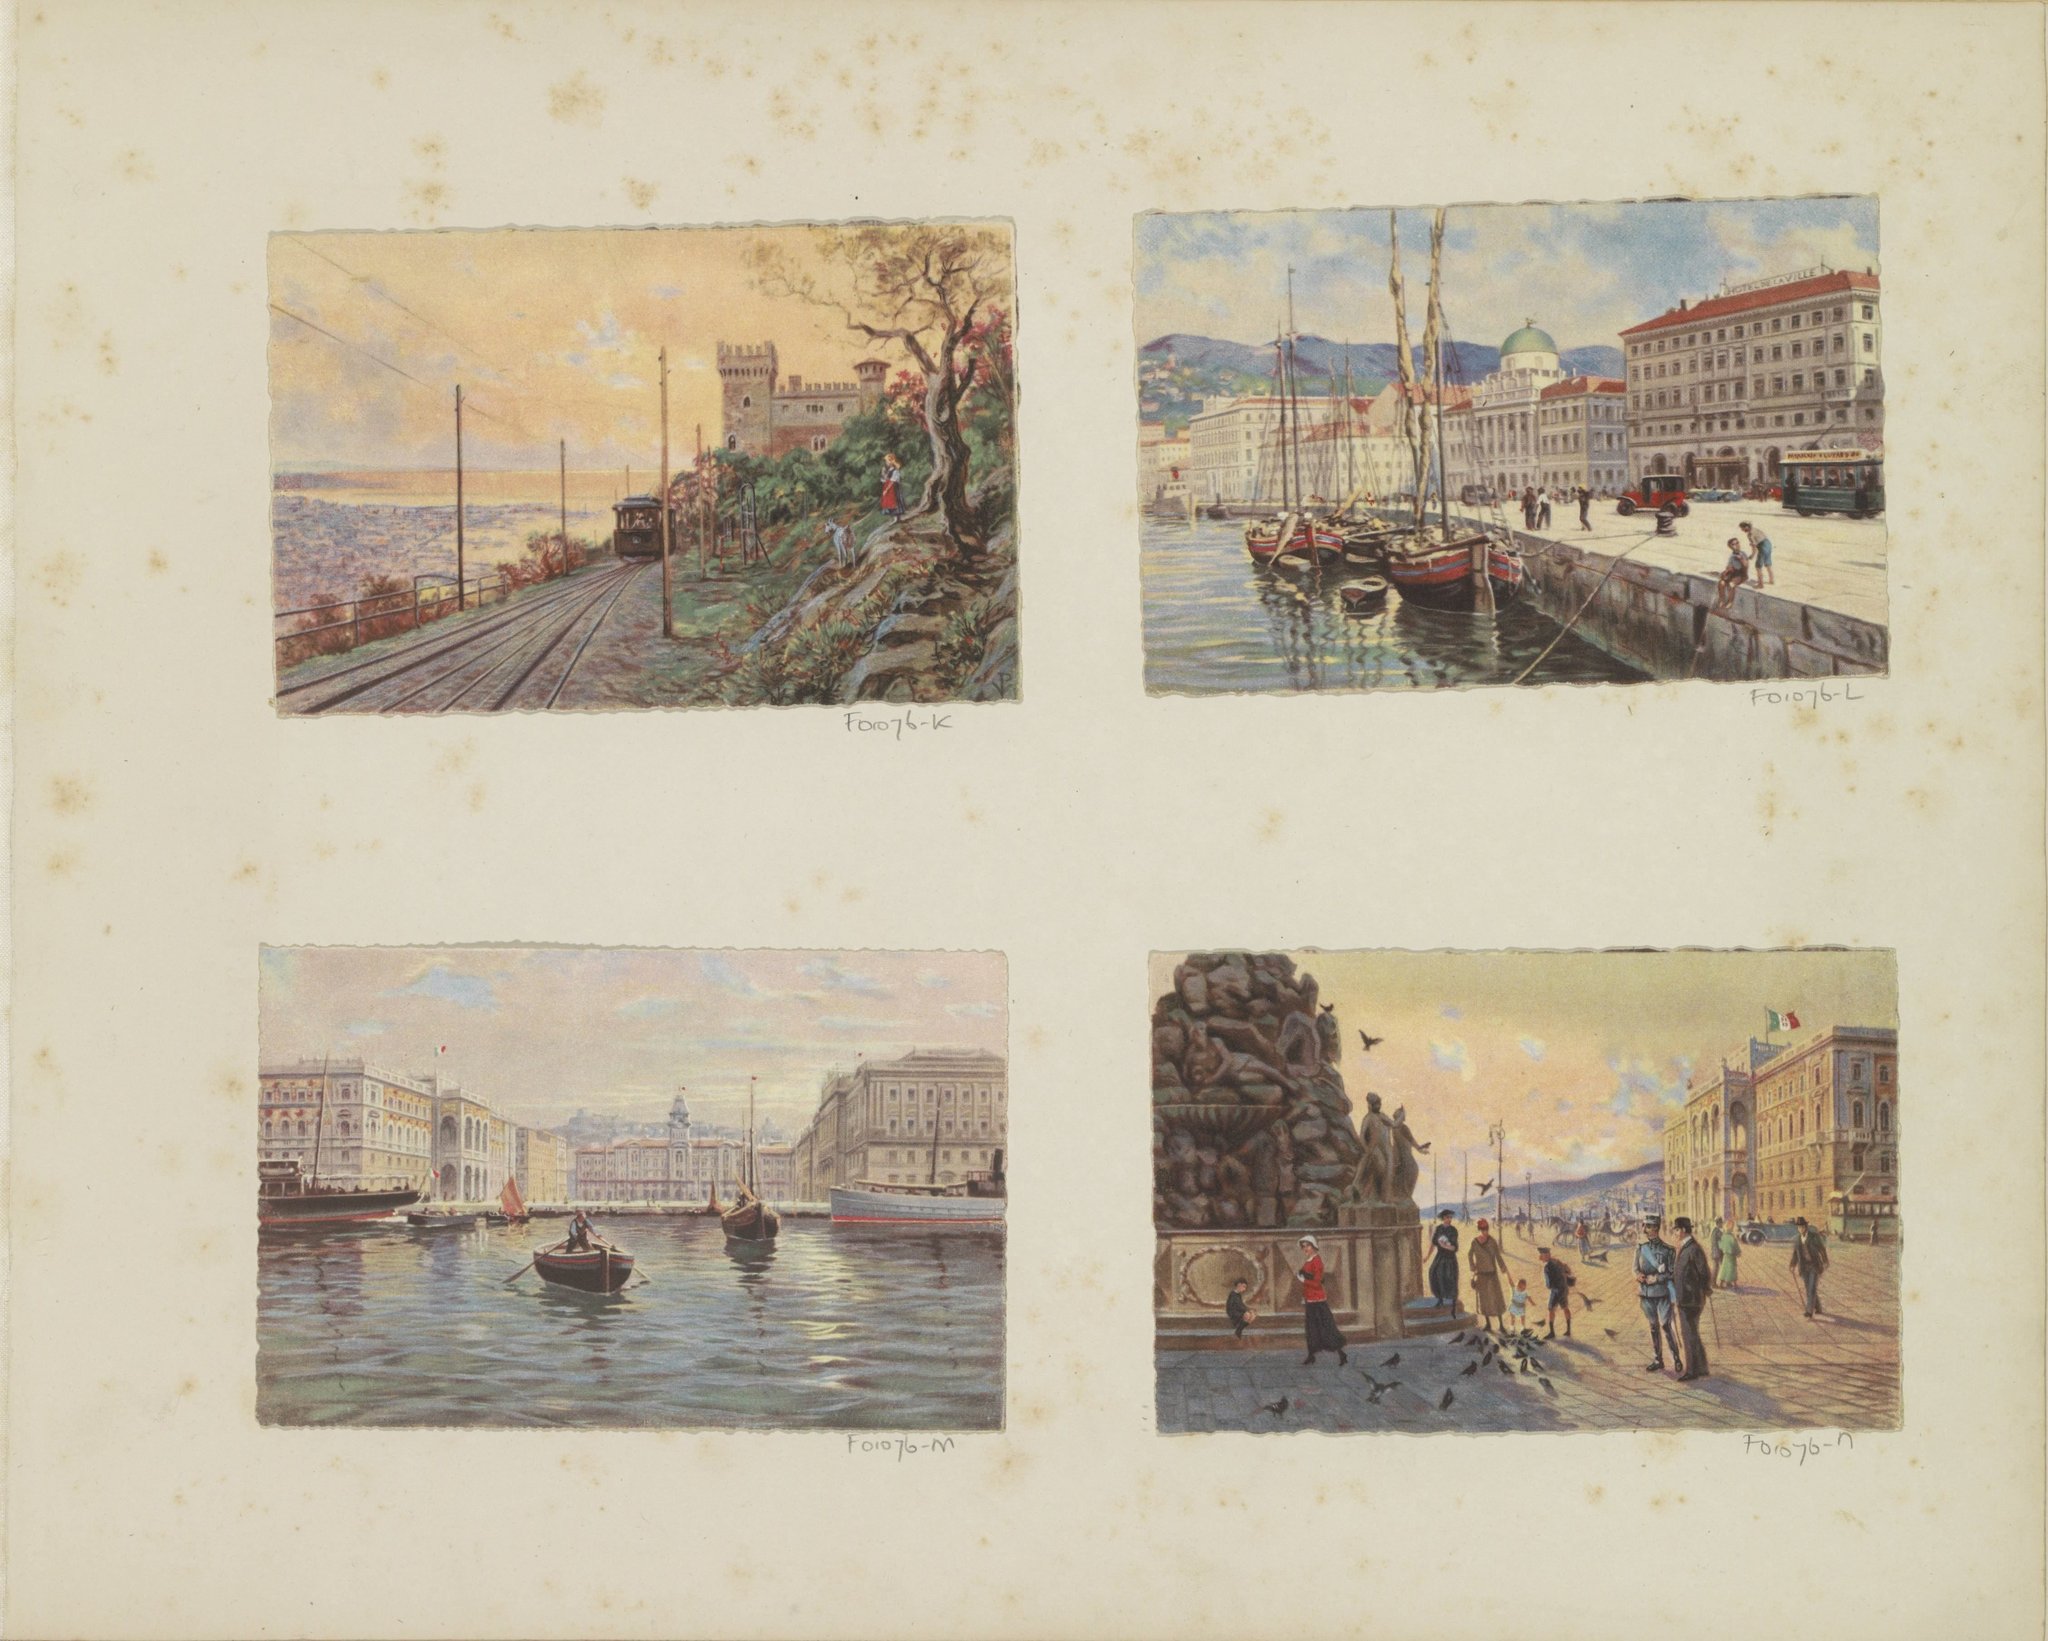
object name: reproduction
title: Fotoreproductie van (vermoedelijk) een tekening van de Fontein van de Vier Continenten in Triëst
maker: Anonymous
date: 1900-1940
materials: cardboard, paper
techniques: offset printed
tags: monument, statue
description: Onderdeel van Album met foto's van spoorwegen in Nederlands-Indië en prentbriefkaarten.